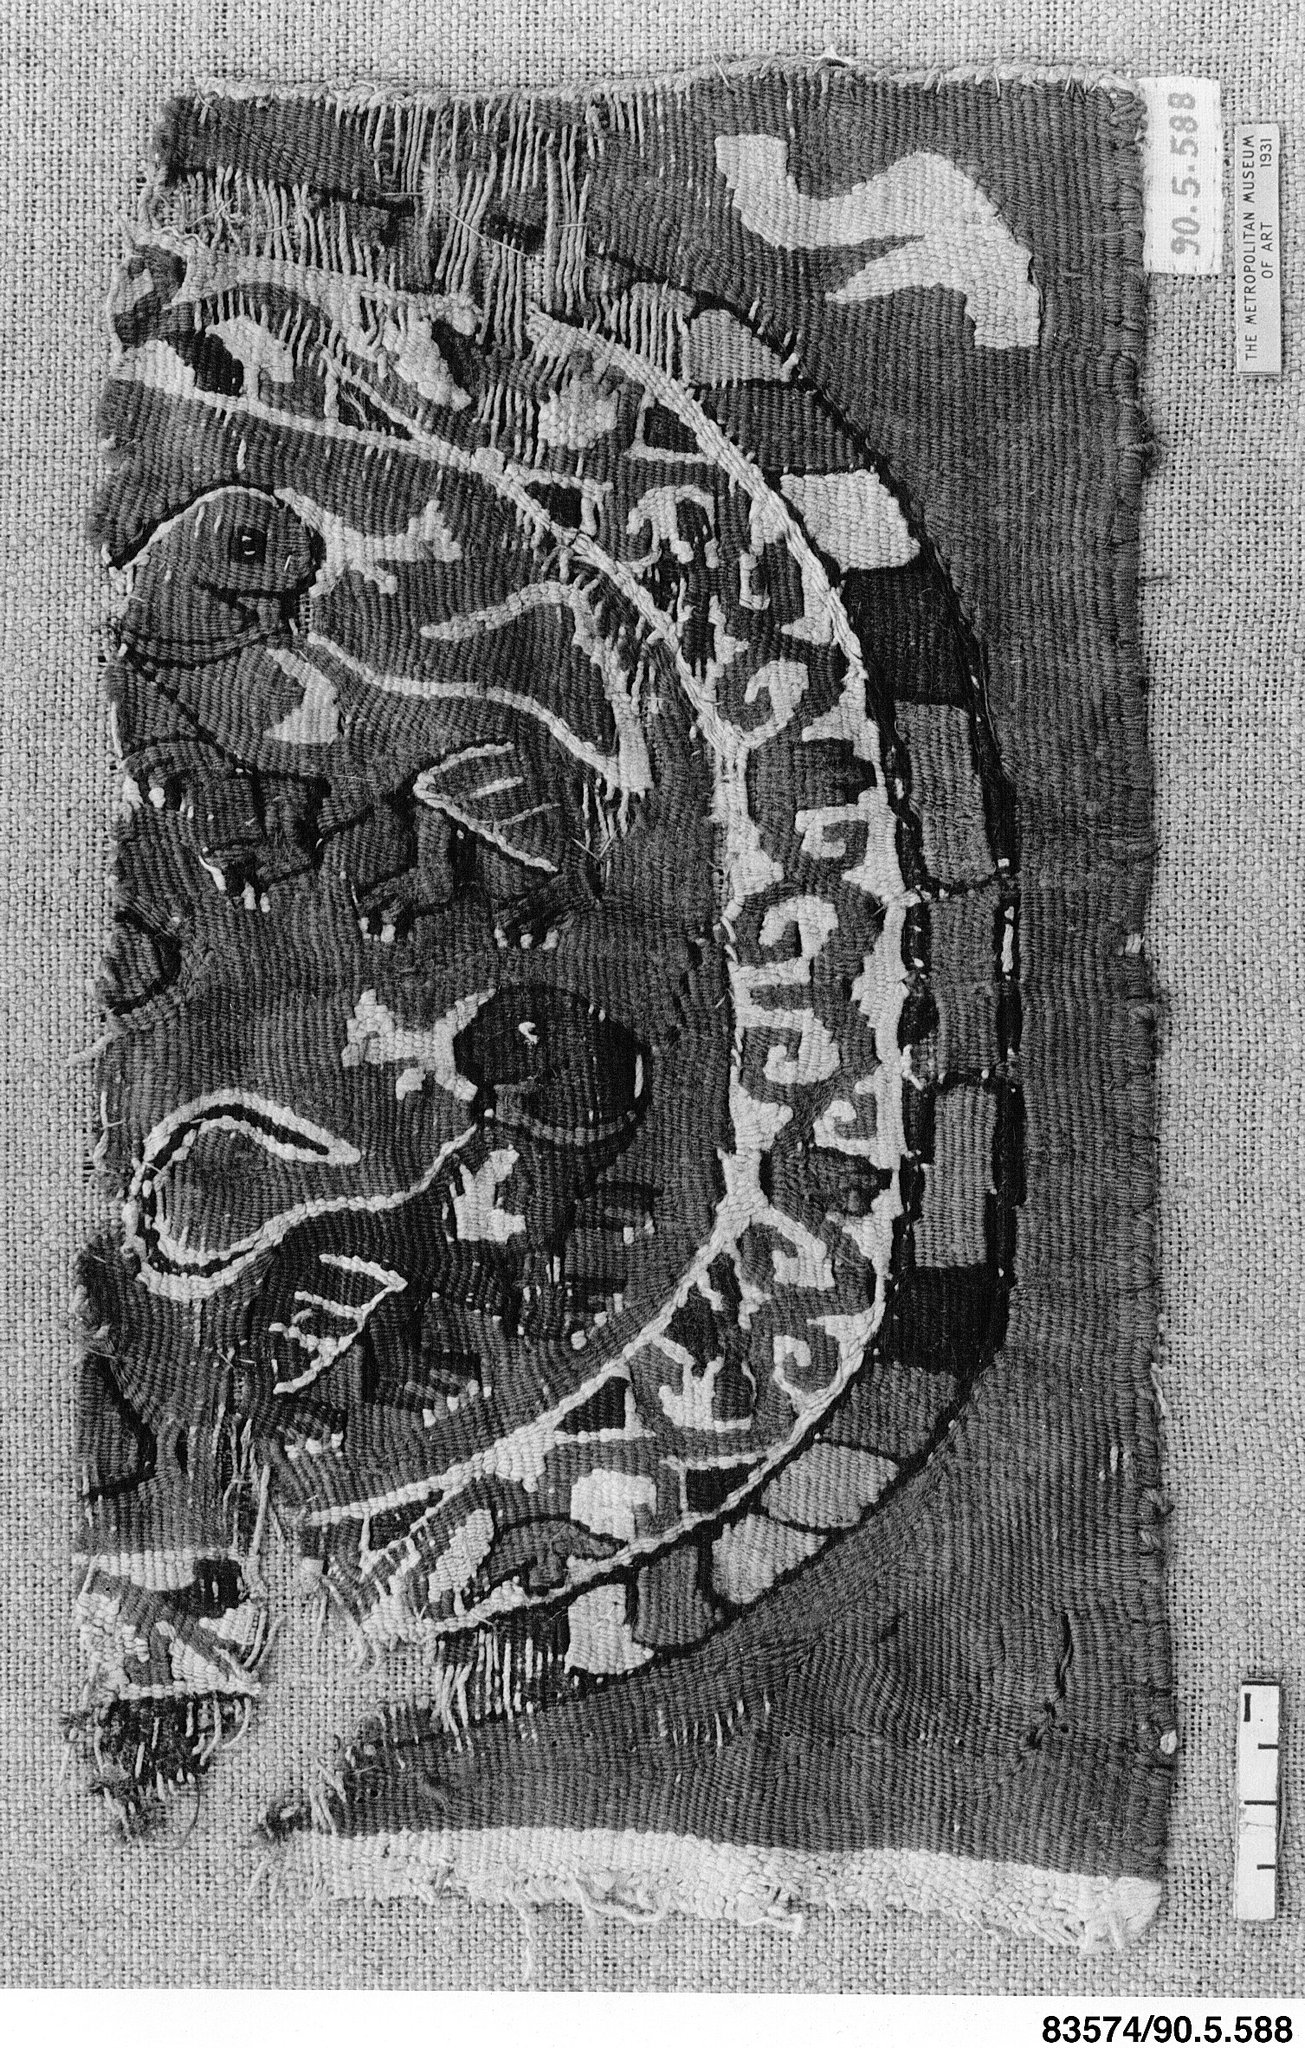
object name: textile fragment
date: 501-700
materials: linen, wool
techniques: weave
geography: egypt